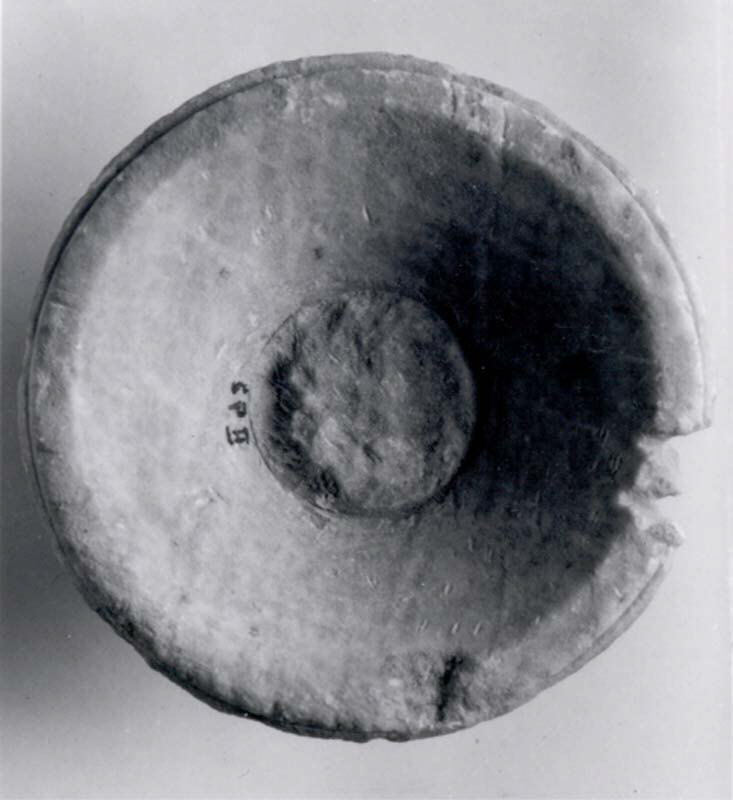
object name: vessel with lid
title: Vessel lid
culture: sasanian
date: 201-700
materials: marble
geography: mesopotamia